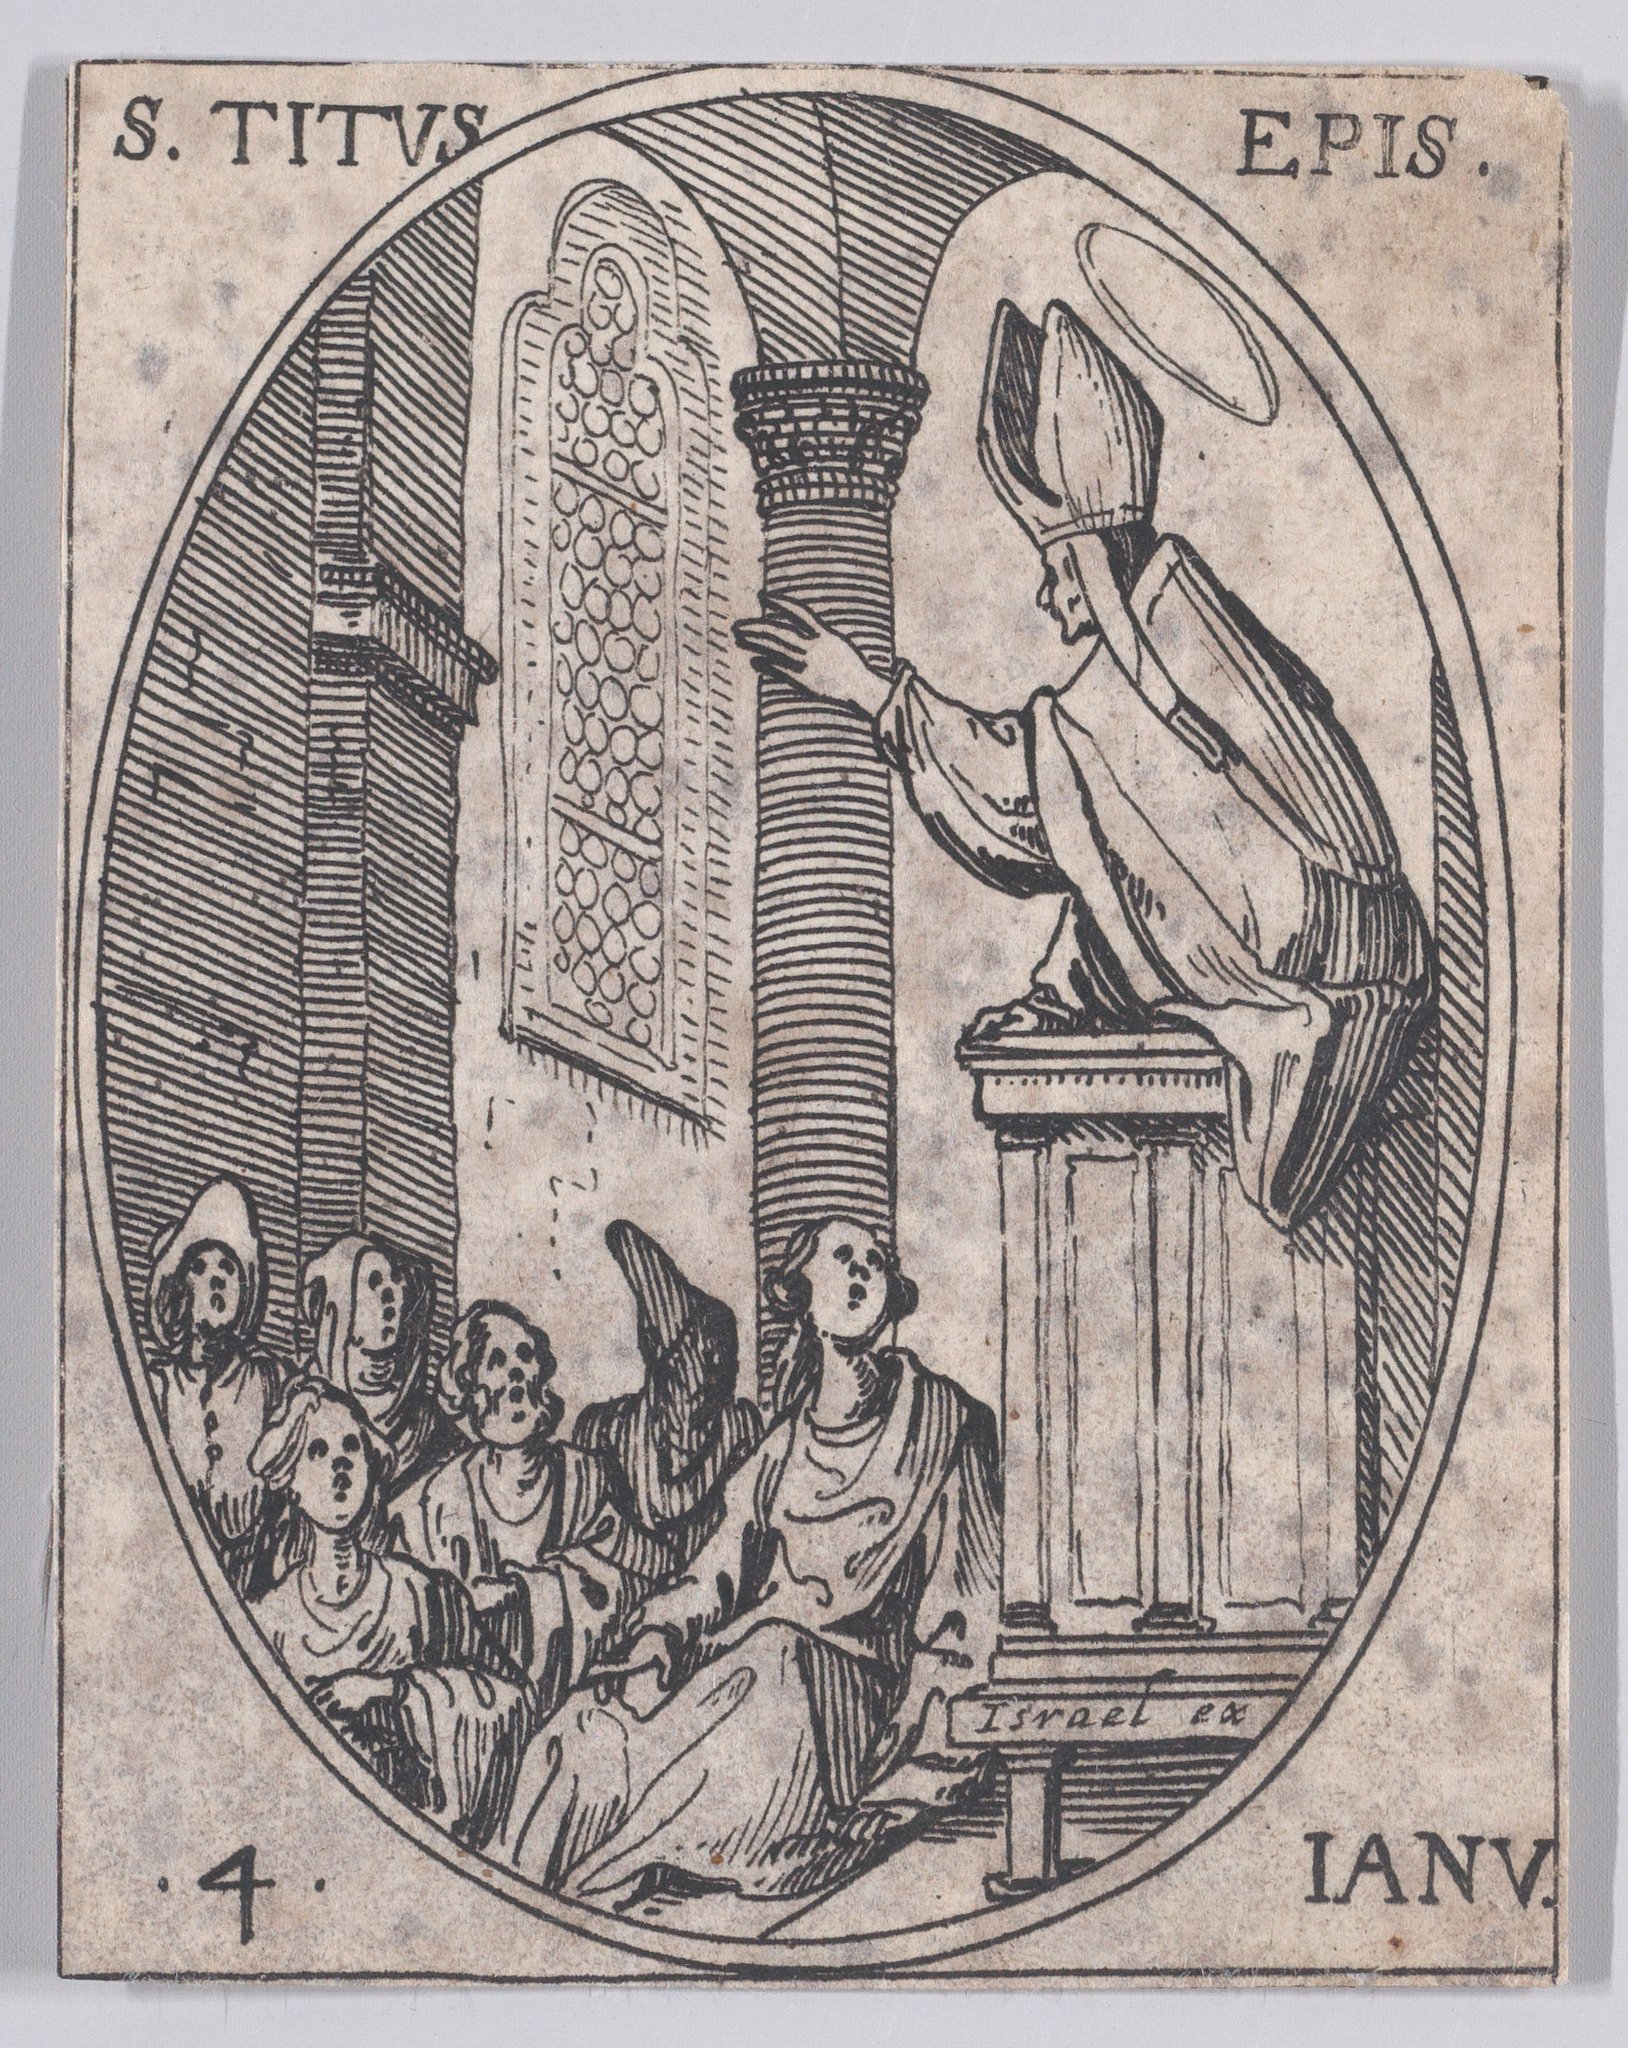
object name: print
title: S. Tite, évêque (St. Titus, Bishop), January 4th, from "Les Images De Tous Les Saincts et Saintes de L'Année" (Images of All of the Saints and Feast Days of the Year)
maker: jacques callot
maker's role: artist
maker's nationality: french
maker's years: 1592-1635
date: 1636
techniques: etching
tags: men,saints